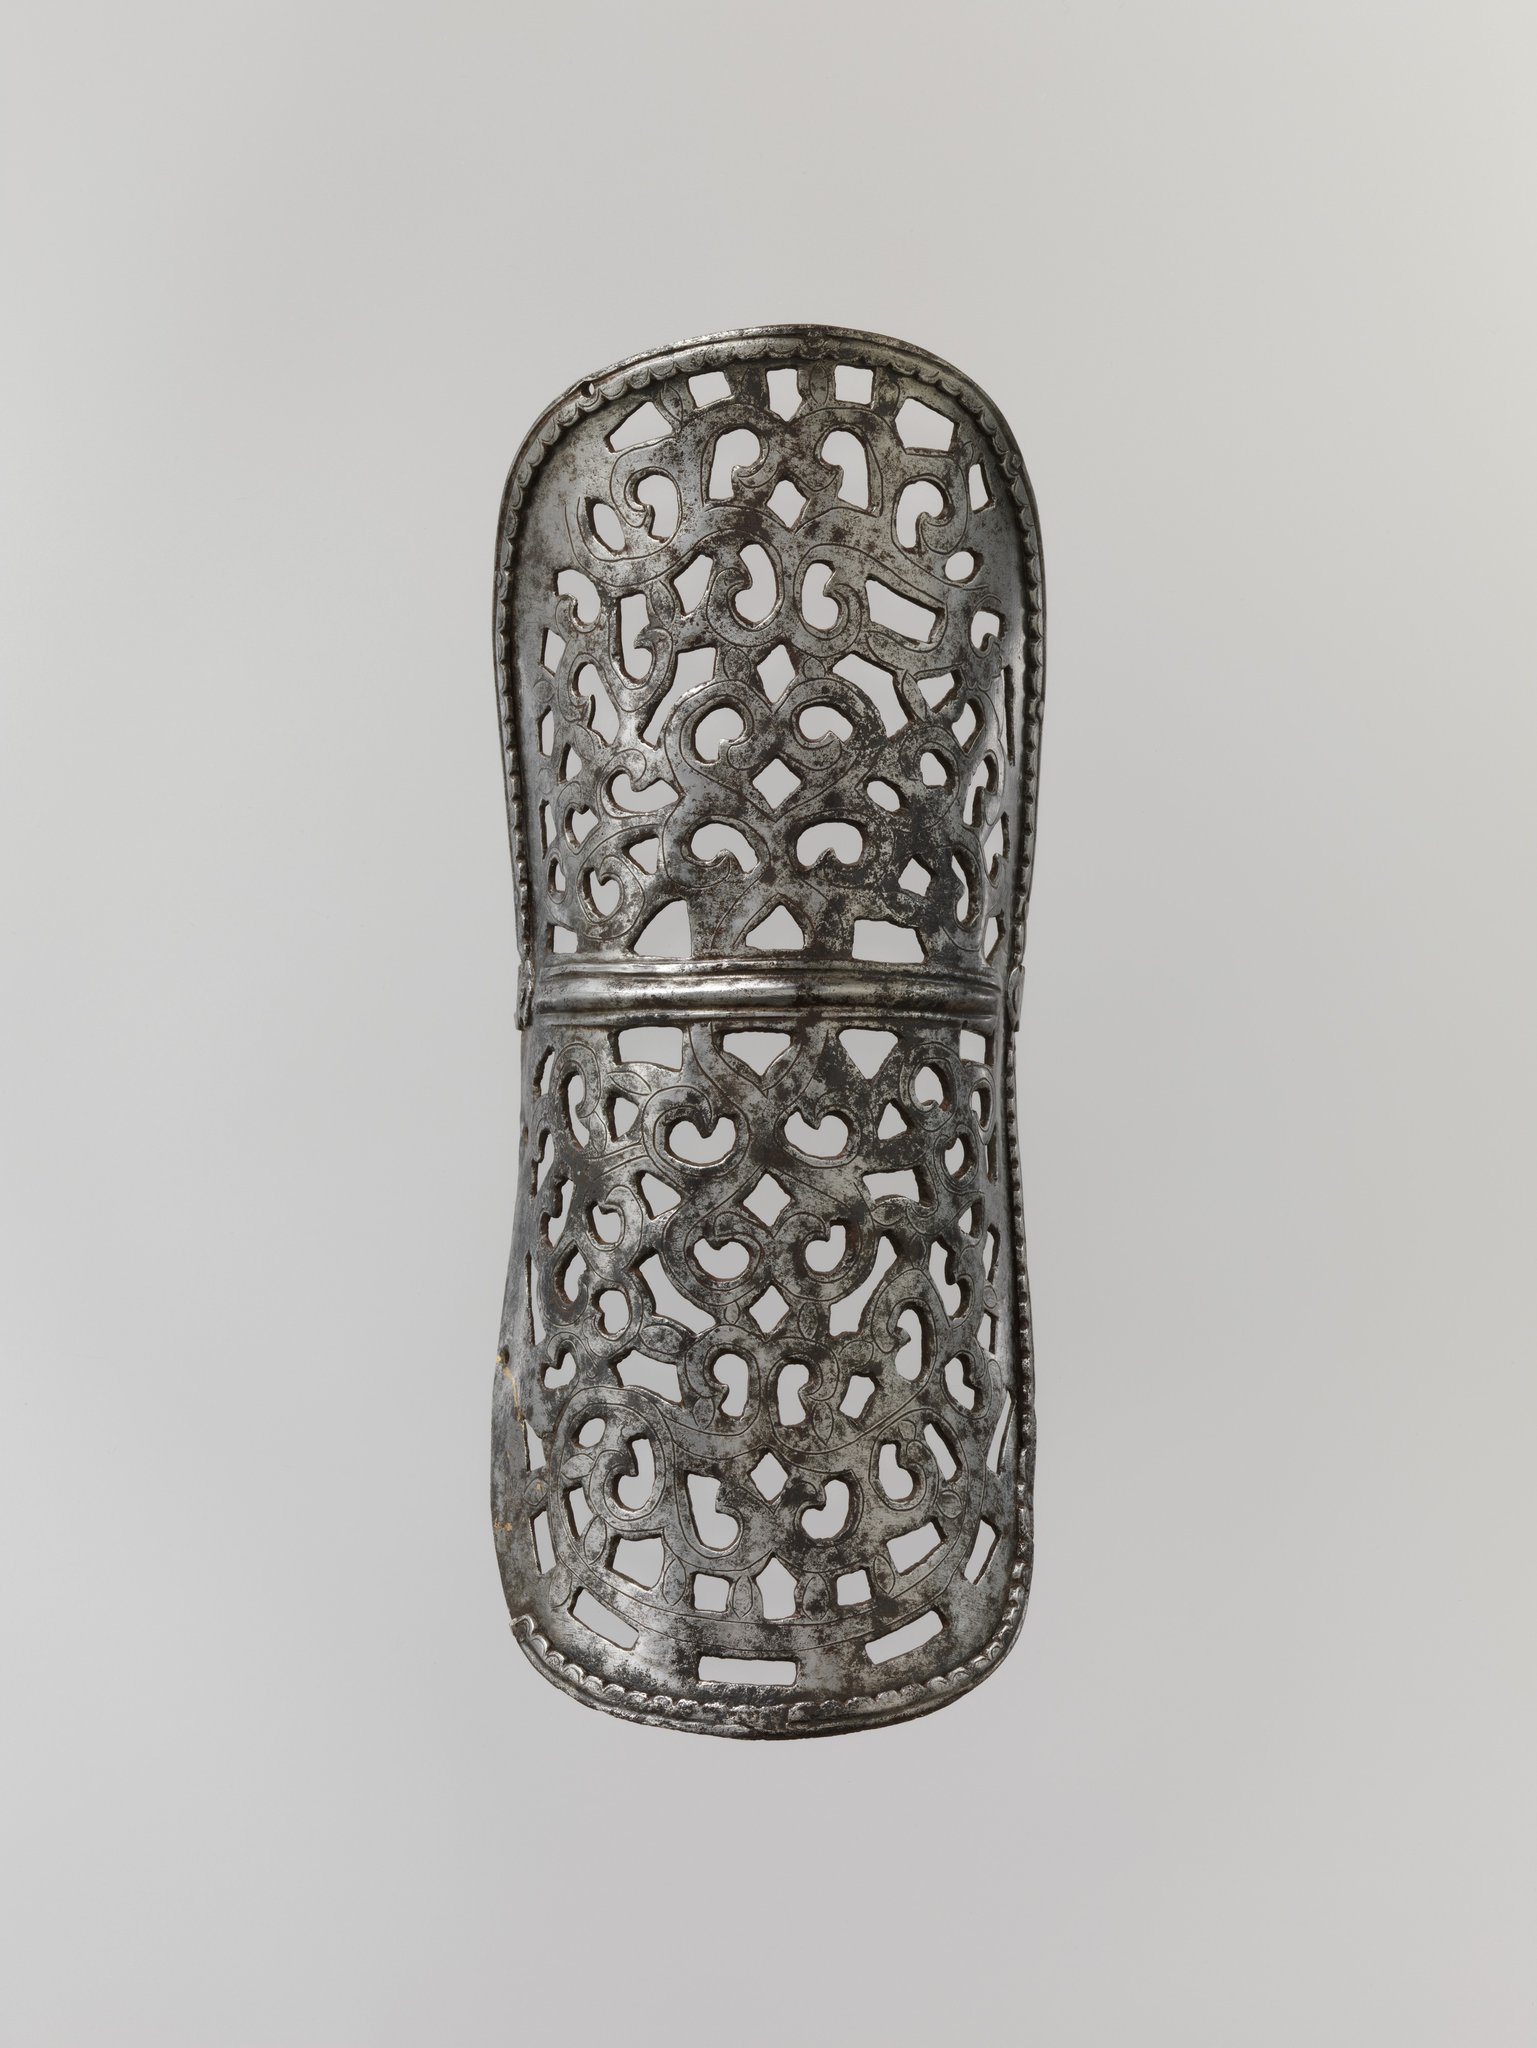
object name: arm defense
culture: mongolian or tibetan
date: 1501-1700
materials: iron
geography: mongolia